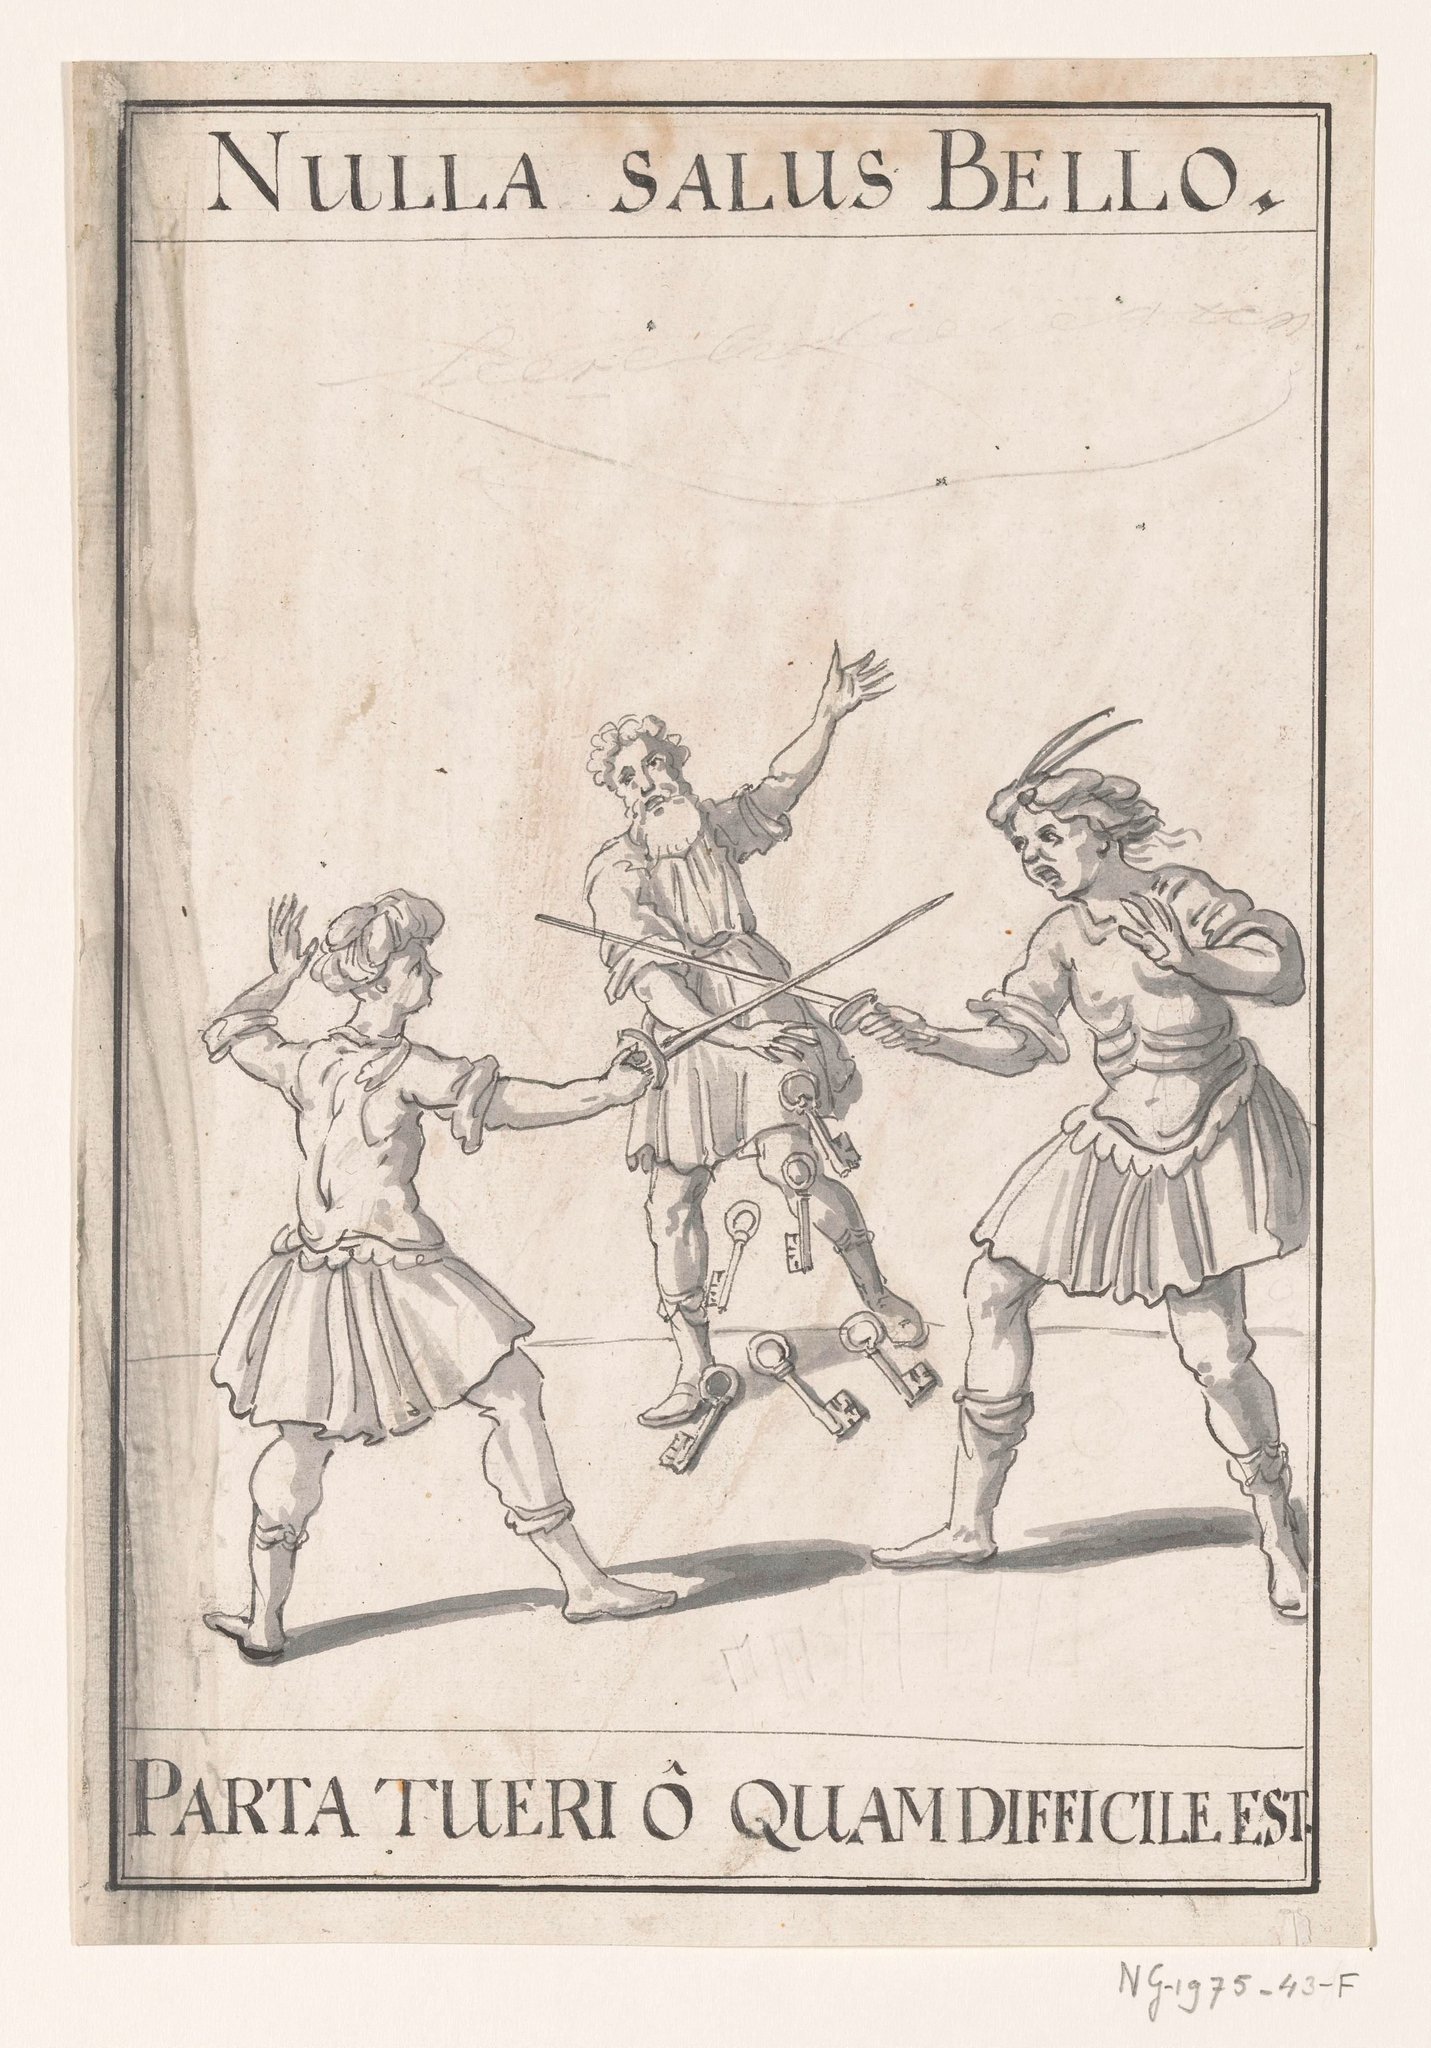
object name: drawing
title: Allegorisch embleem bij de Vrede van Rijswijk, 1697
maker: Anonymous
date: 1697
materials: ink, paper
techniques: brush, pen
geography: northern netherlands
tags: key, hand-to-hand fighting (~ battle), festivities on events of national importance (+ festive decoration ~ festive activities)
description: Embleem met twee zwaardvechtende mannen waarachter men die sleutels laat vallen. Opschrift: Nulla salus Bello / Parta tueri ô quam difficile est. Op de achterzijde kindertekening van o.a. een kerk. Ontwerp voor een decoratie bij de viering van de Vrede van Rijswijk in 1697.